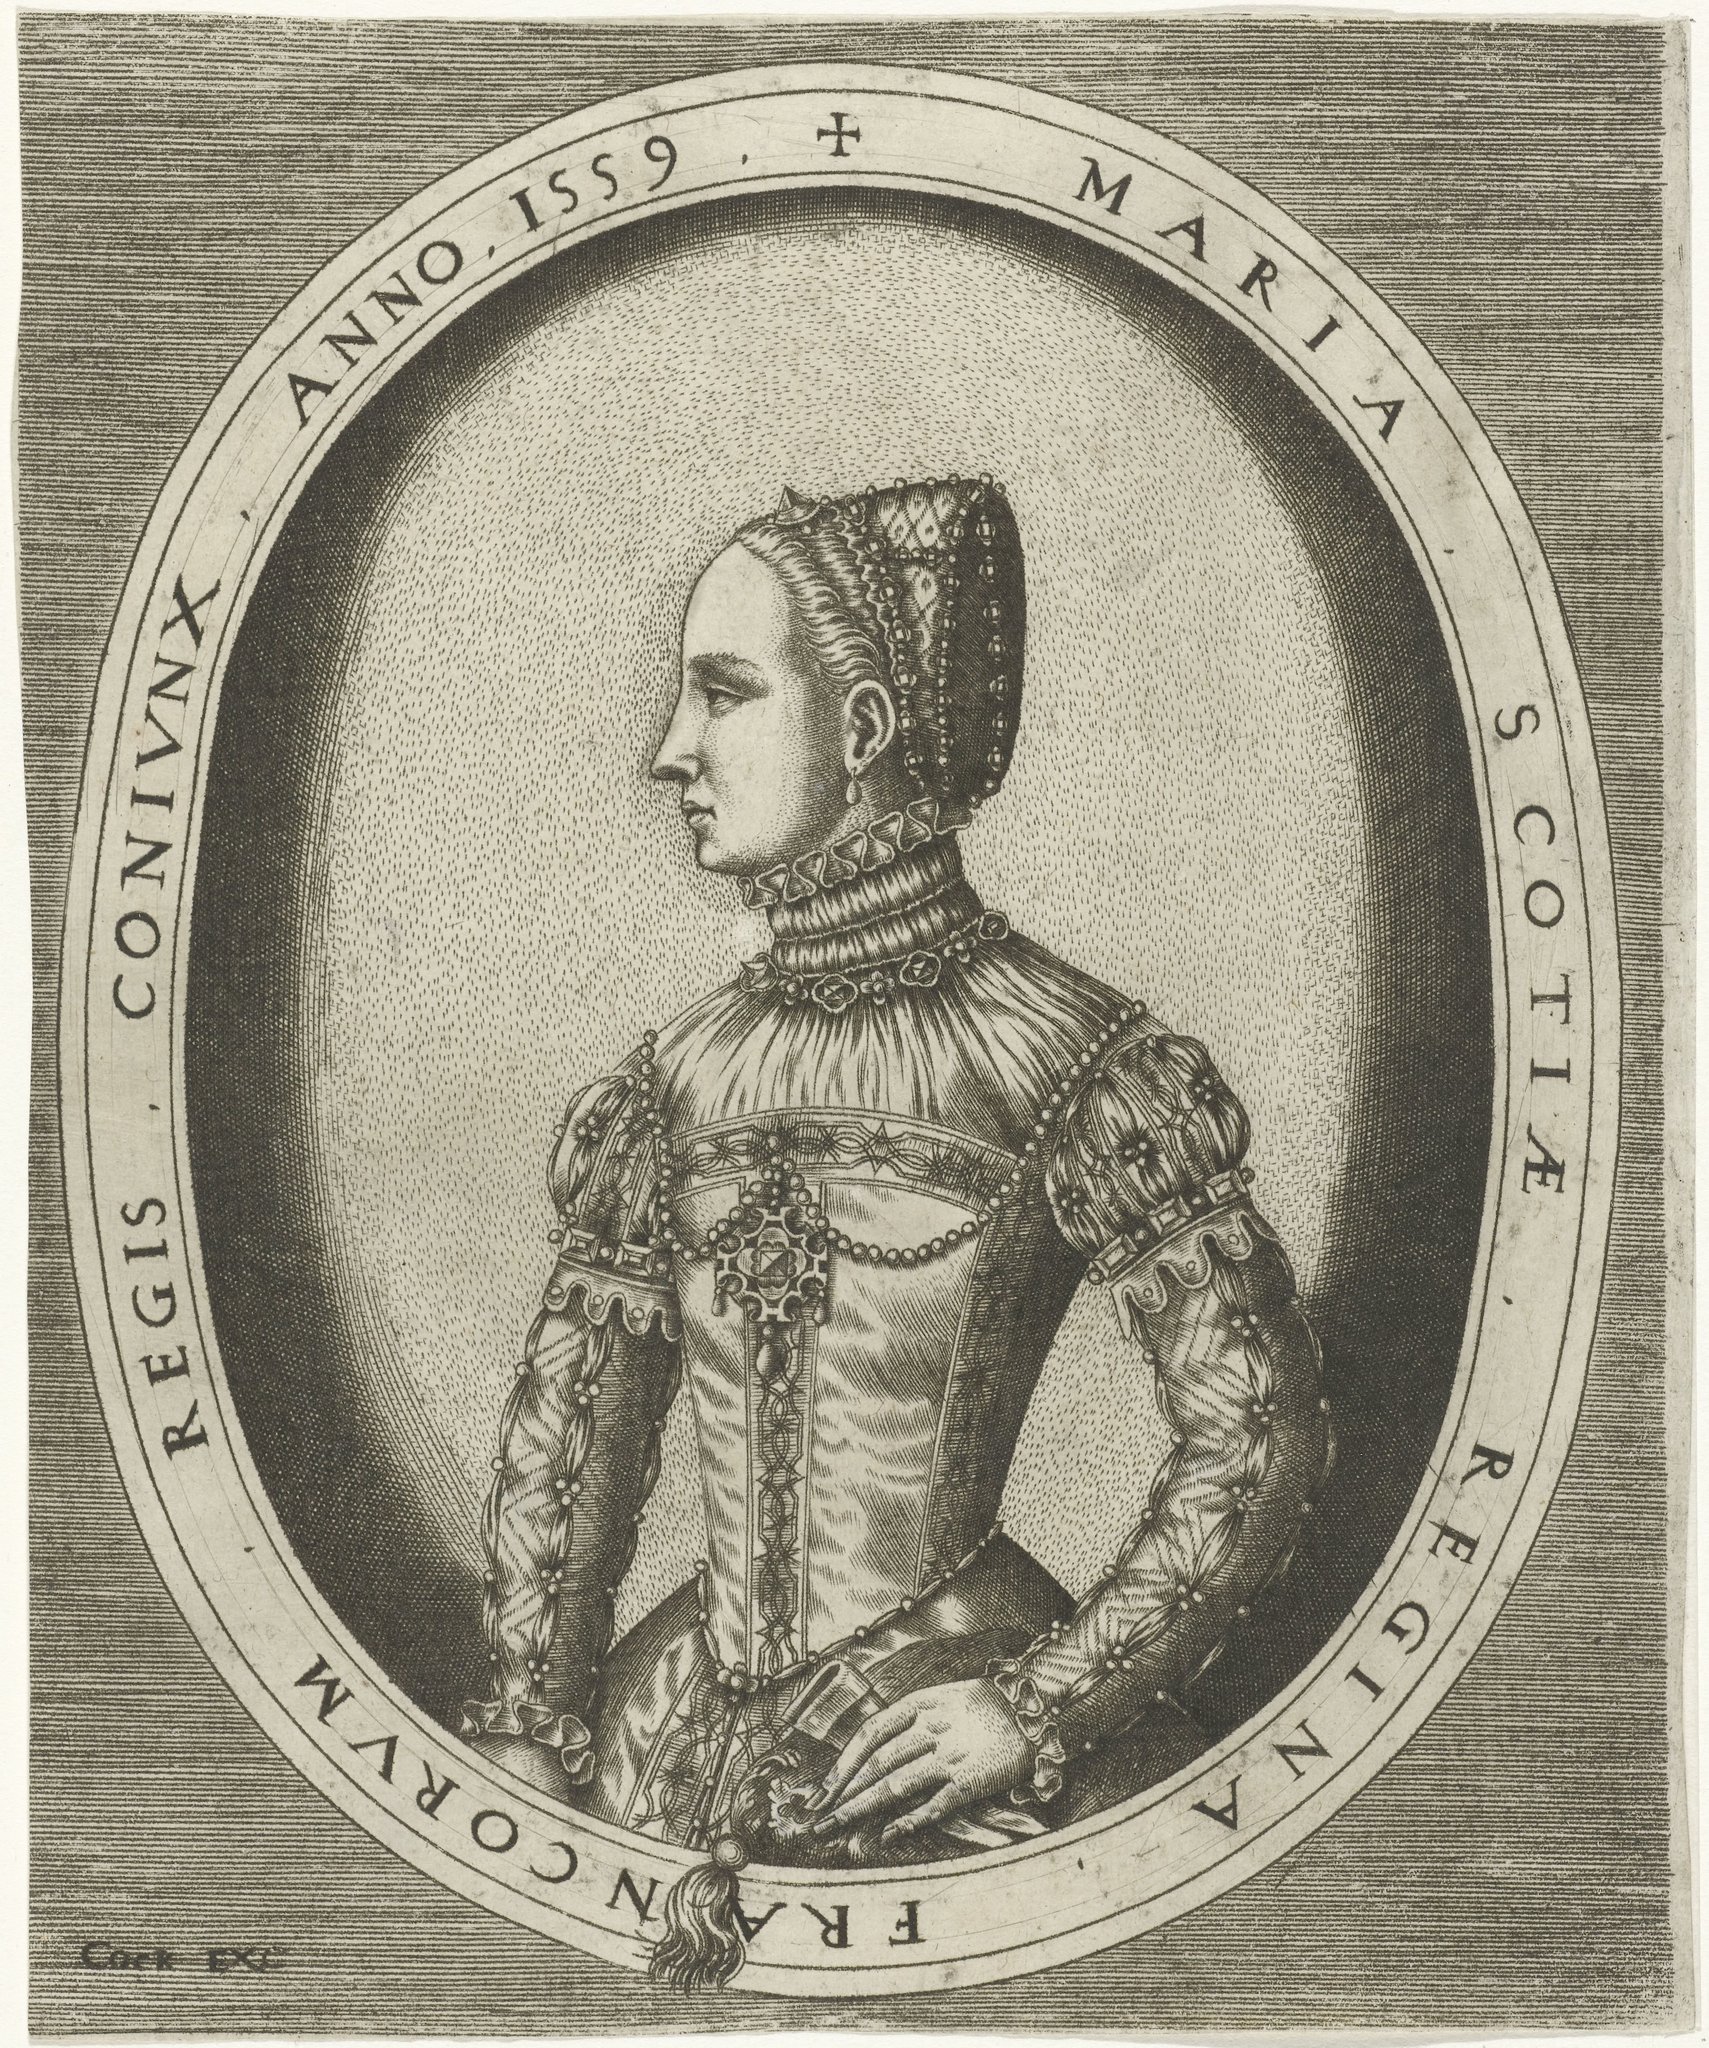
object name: print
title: Portret van koningin Maria I Stuart van Schotland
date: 1559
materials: paper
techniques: engraving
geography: antwerp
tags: fotheringay castle, maria i stuart (koningin van schotland)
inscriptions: collector's mark: Lugt 2228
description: Portret van Maria I Stuart, koningin van Schotland, ten halven lijve naar links in een ovale lijst met randschrift in het Latijn.